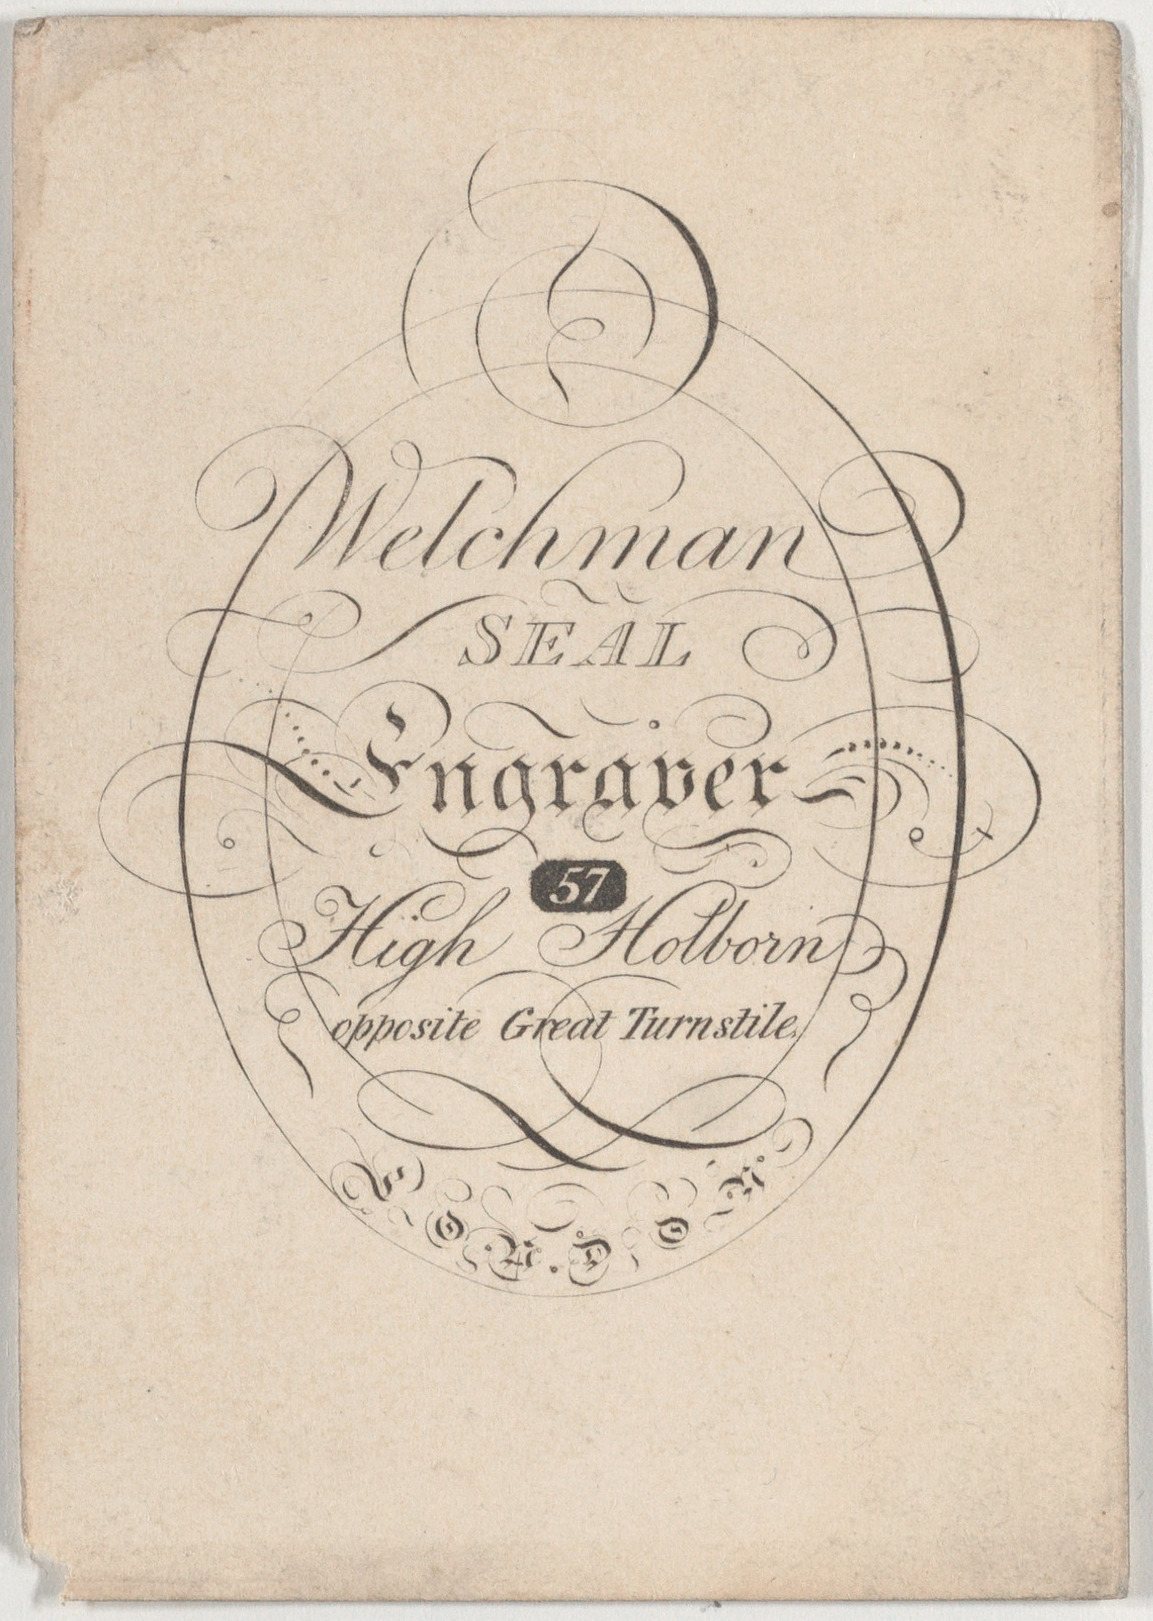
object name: print, trade card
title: Trade Card for Welchman, seal engraver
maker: anonymous, british, early 19th century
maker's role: artist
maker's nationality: british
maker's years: 1800-1850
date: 1801-1833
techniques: engraving